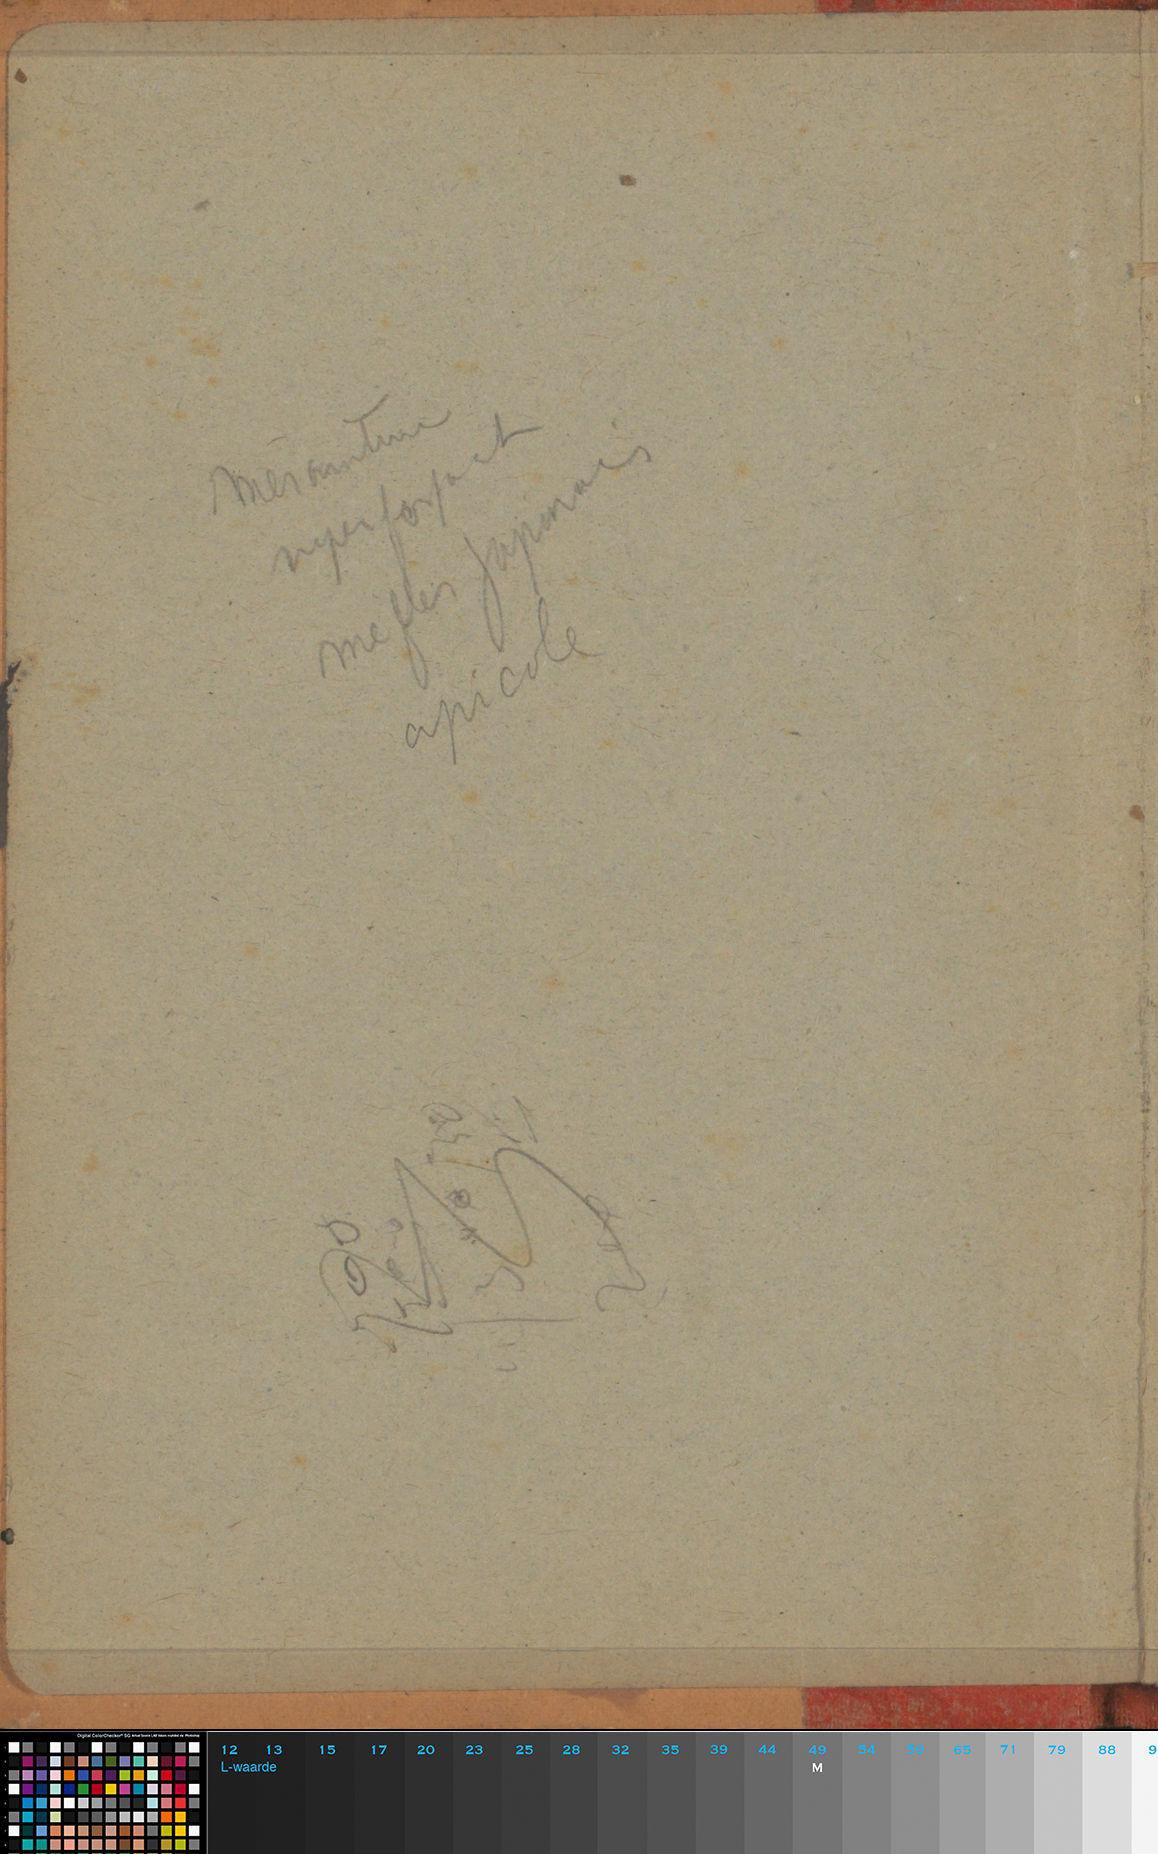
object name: endleaf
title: Annotatie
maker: marius bauer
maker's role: draughtsman, print maker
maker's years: 1867-1932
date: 1909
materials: paper, pencil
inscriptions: annotation: ‘mer[...] melles japonais/ apicole’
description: Voorste schutblad uit een schetsboek met 67 bladen.